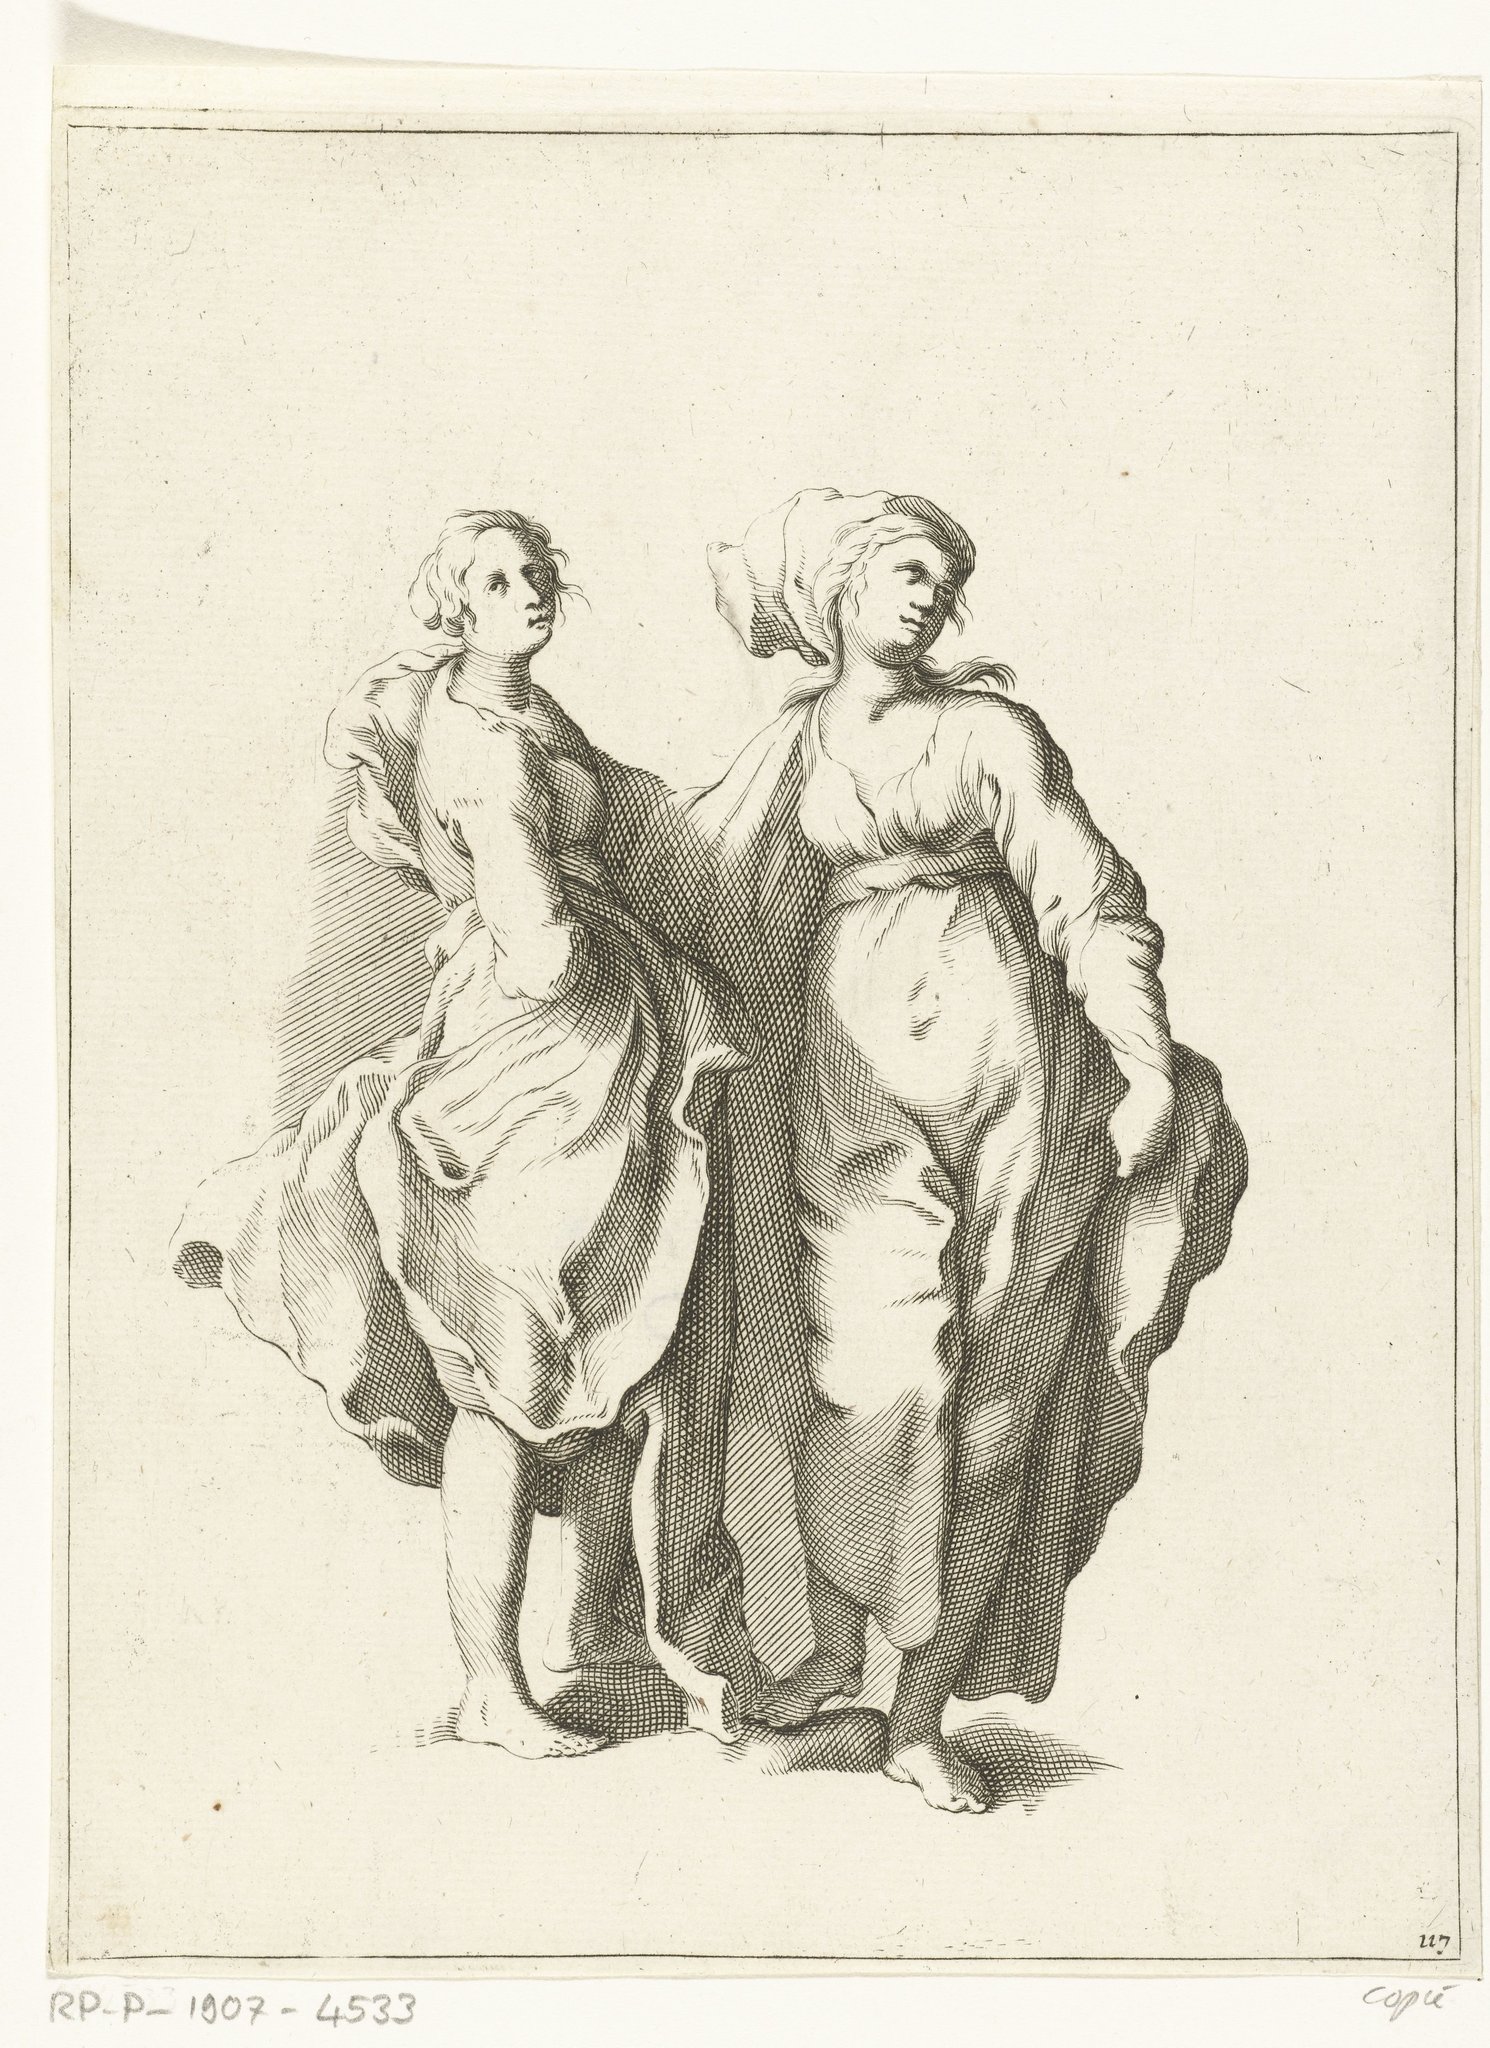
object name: print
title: Twee vrouwen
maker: Anonymous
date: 1679-1750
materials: paper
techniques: engraving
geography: netherlands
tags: adult woman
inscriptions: collector's mark: Lugt 2228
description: Twee vrouwen, vooraanzicht, met losse kleding. Kopie naar een voorstelling uit het tekenboek van Abraham Bloemaert, in de editie van Nicolaas Visscher.